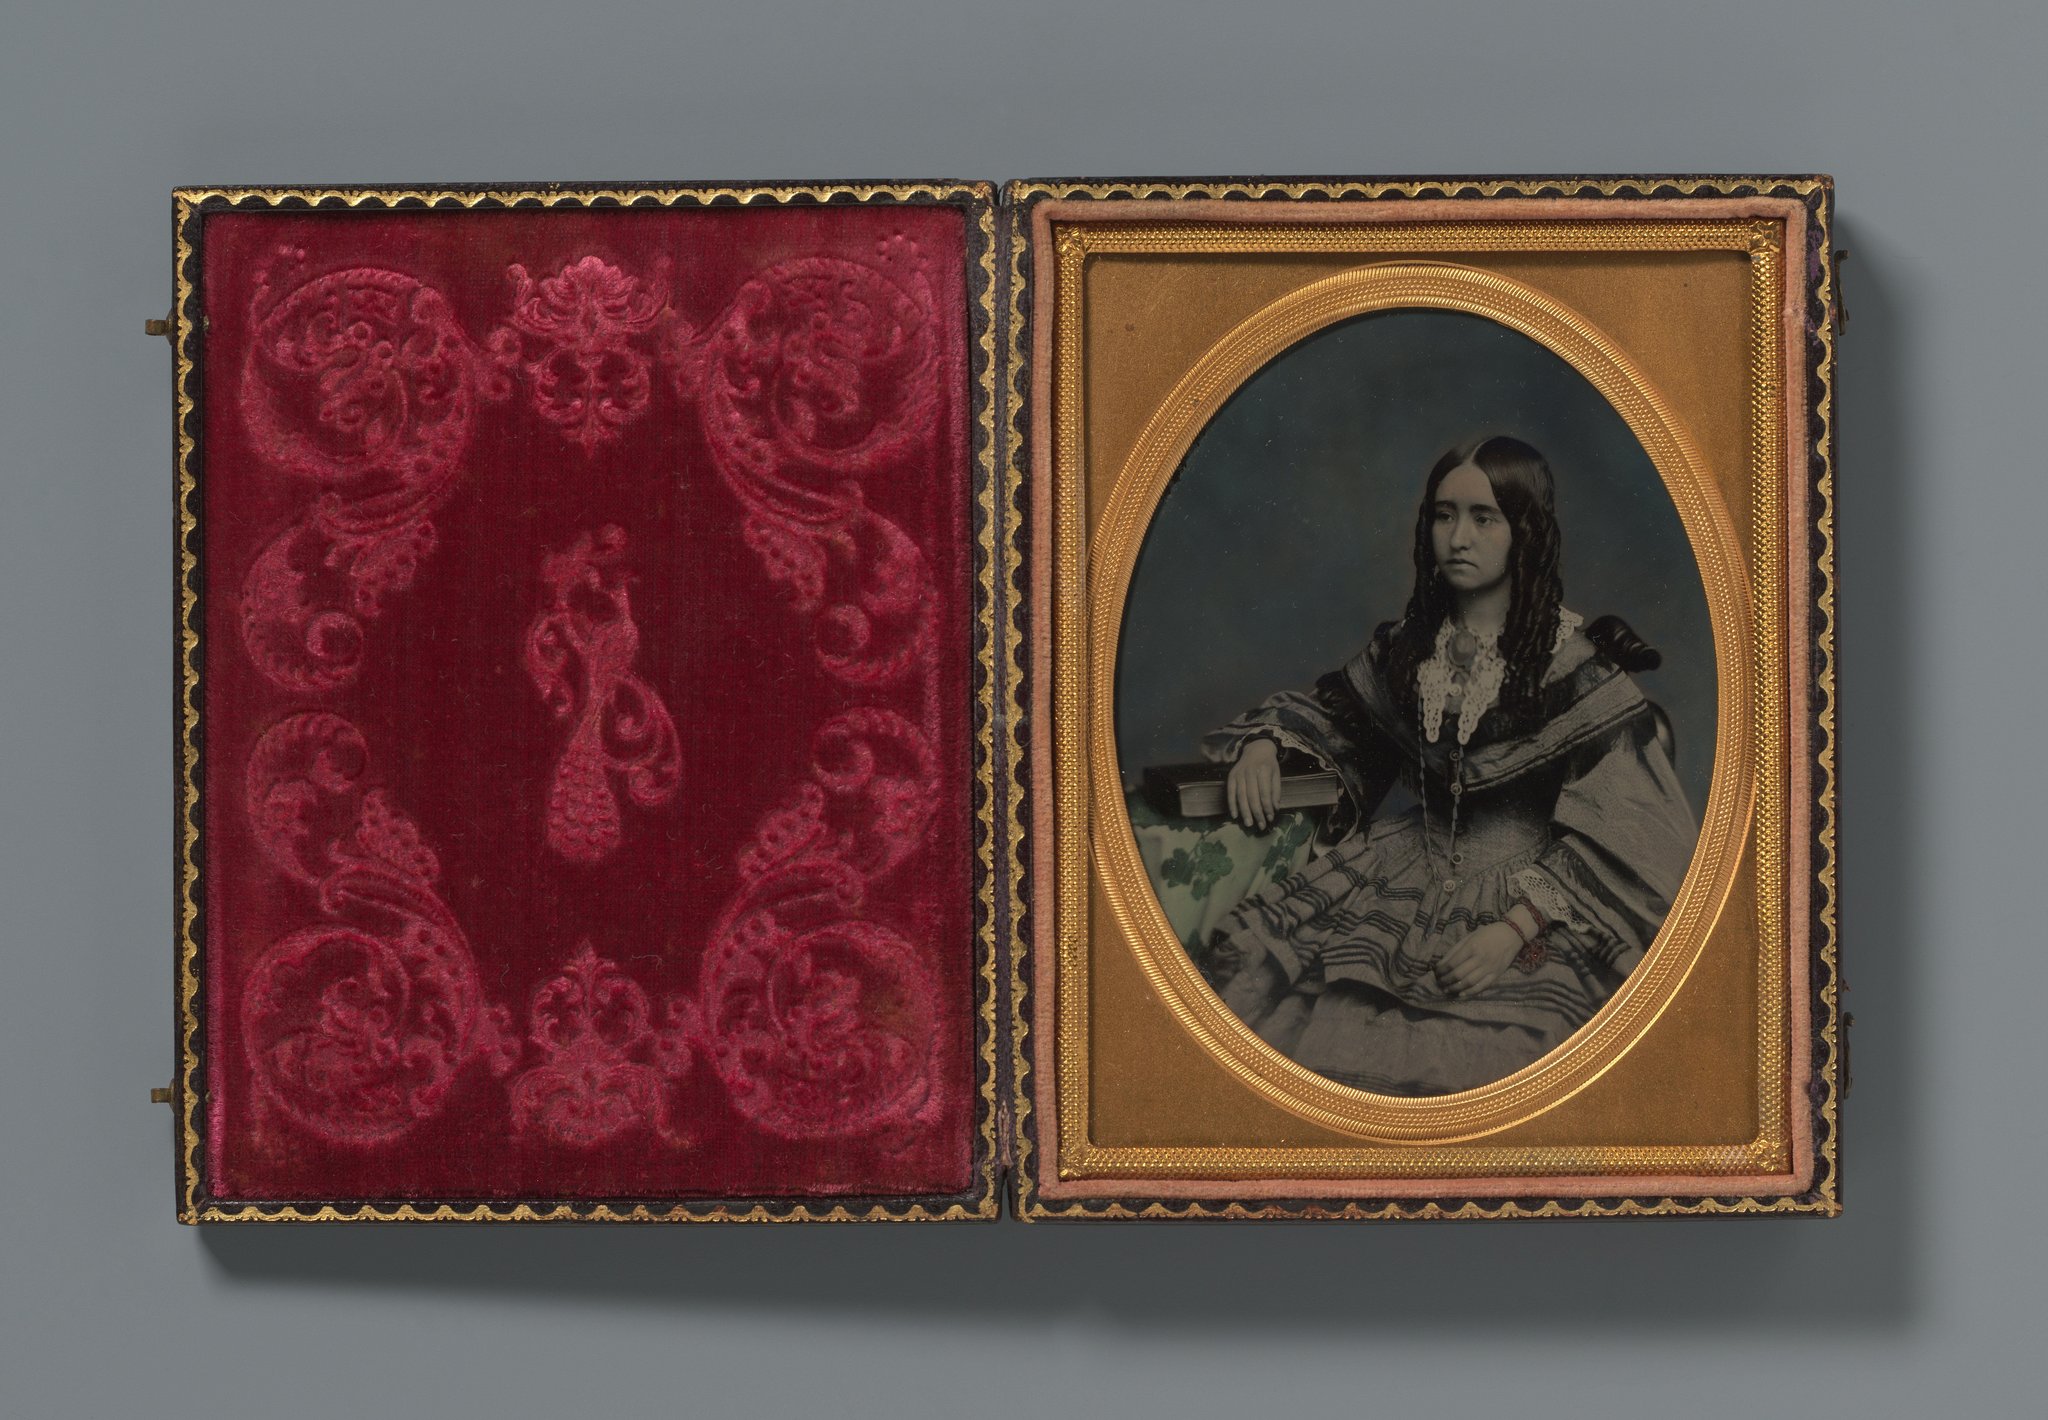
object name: photograph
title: Portret van een onbekende jonge vrouw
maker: Anonymous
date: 1855-1870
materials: glass, leather, metal, velvet, wood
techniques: ambrotype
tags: adolescent, young woman, maiden, historical persons - bb - woman